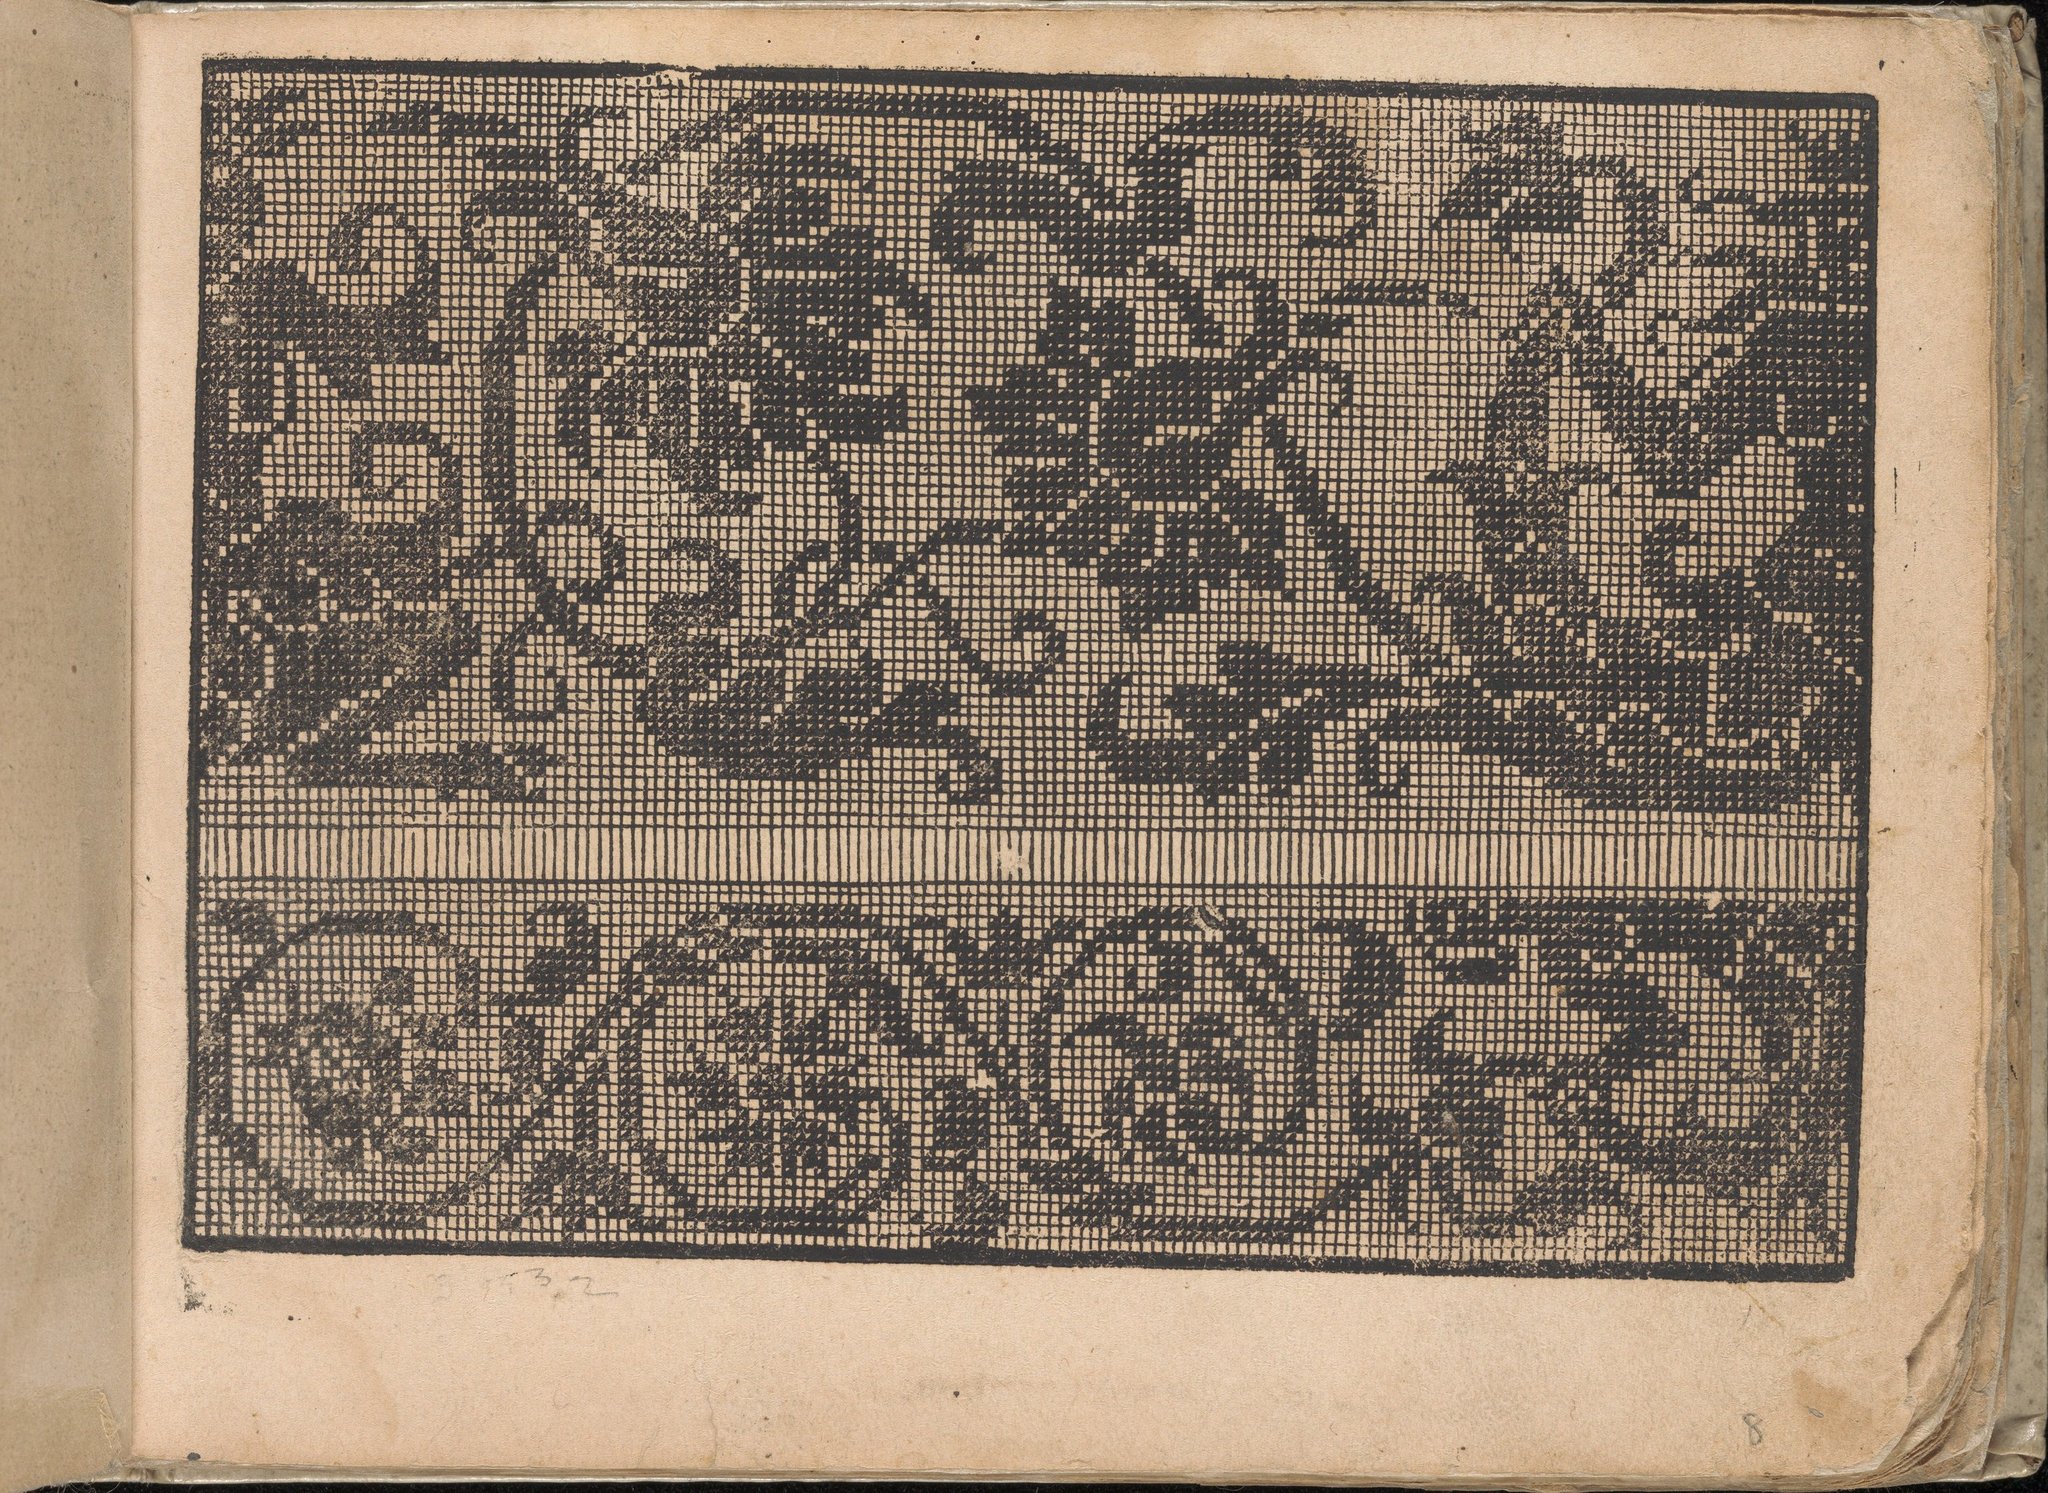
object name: book print ornament architecture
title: Neu künstlich Modelbuch (page 8r)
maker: bernhard jobin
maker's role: publisher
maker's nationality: swiss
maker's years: 1535-1597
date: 1598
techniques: woodcut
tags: flowers